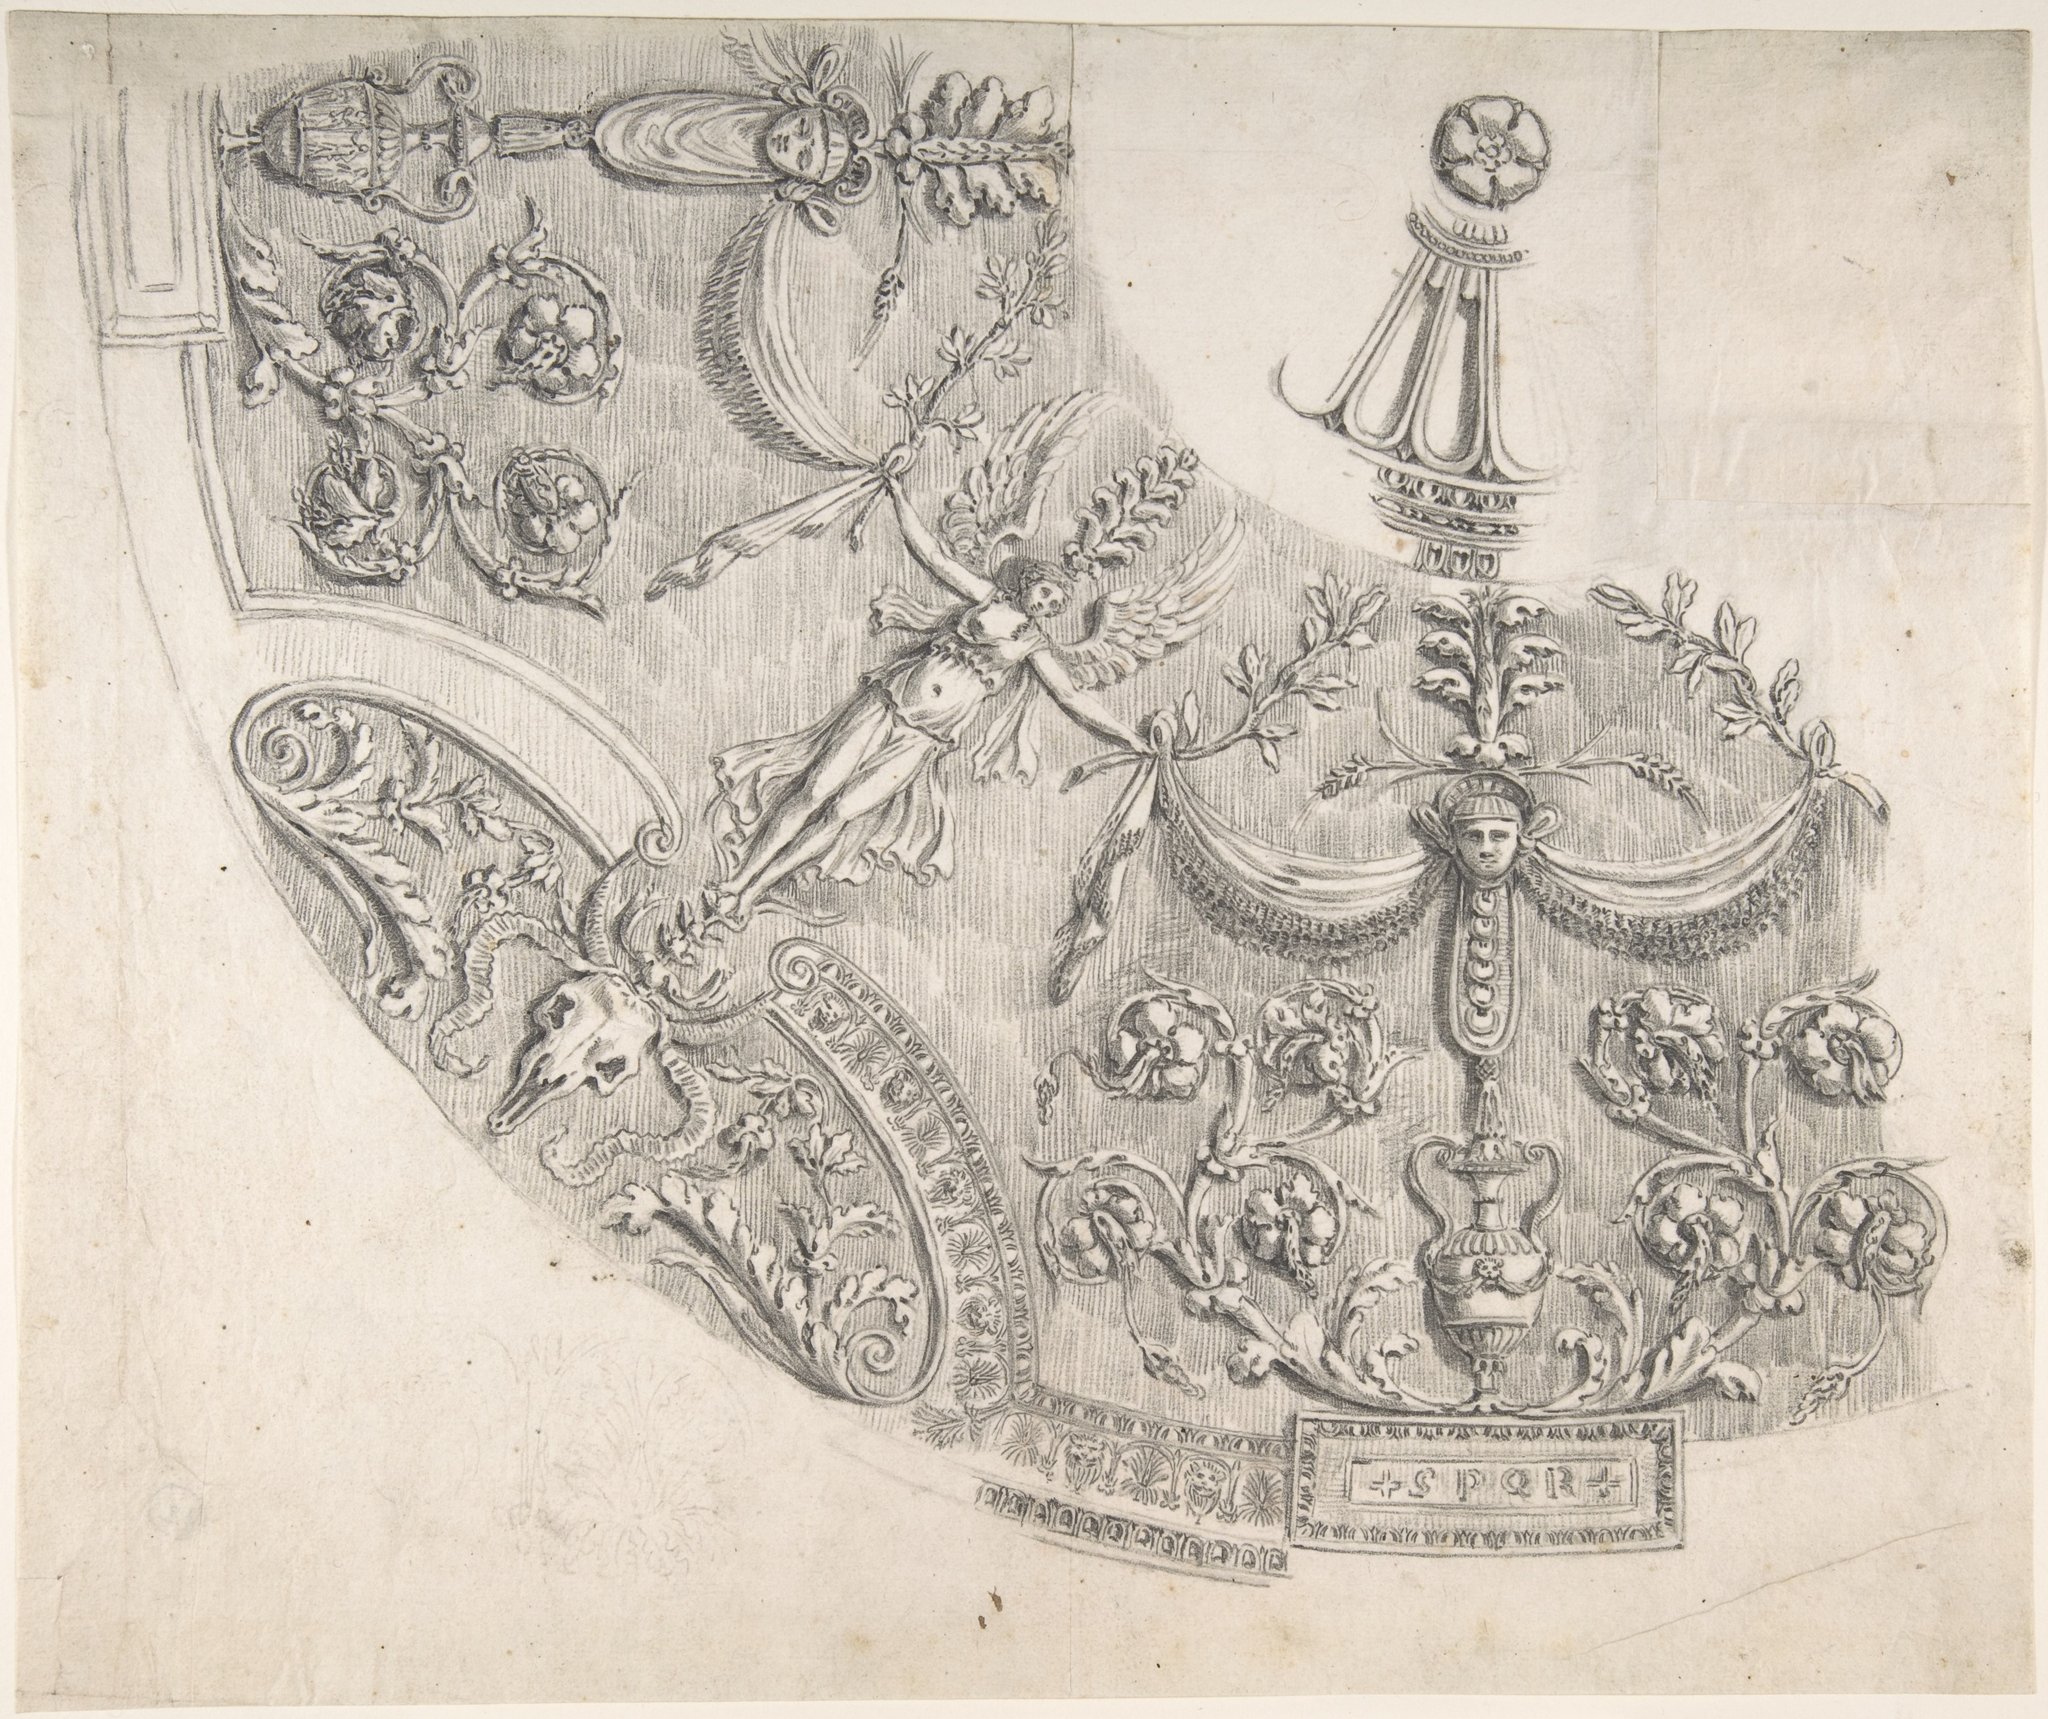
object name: drawing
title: Segment of Circular Celing Vault, Palazzo Mattei, Rome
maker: thomas hardwick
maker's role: artist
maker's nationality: british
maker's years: 1752-1829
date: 1776-1779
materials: graphite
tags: ceilings